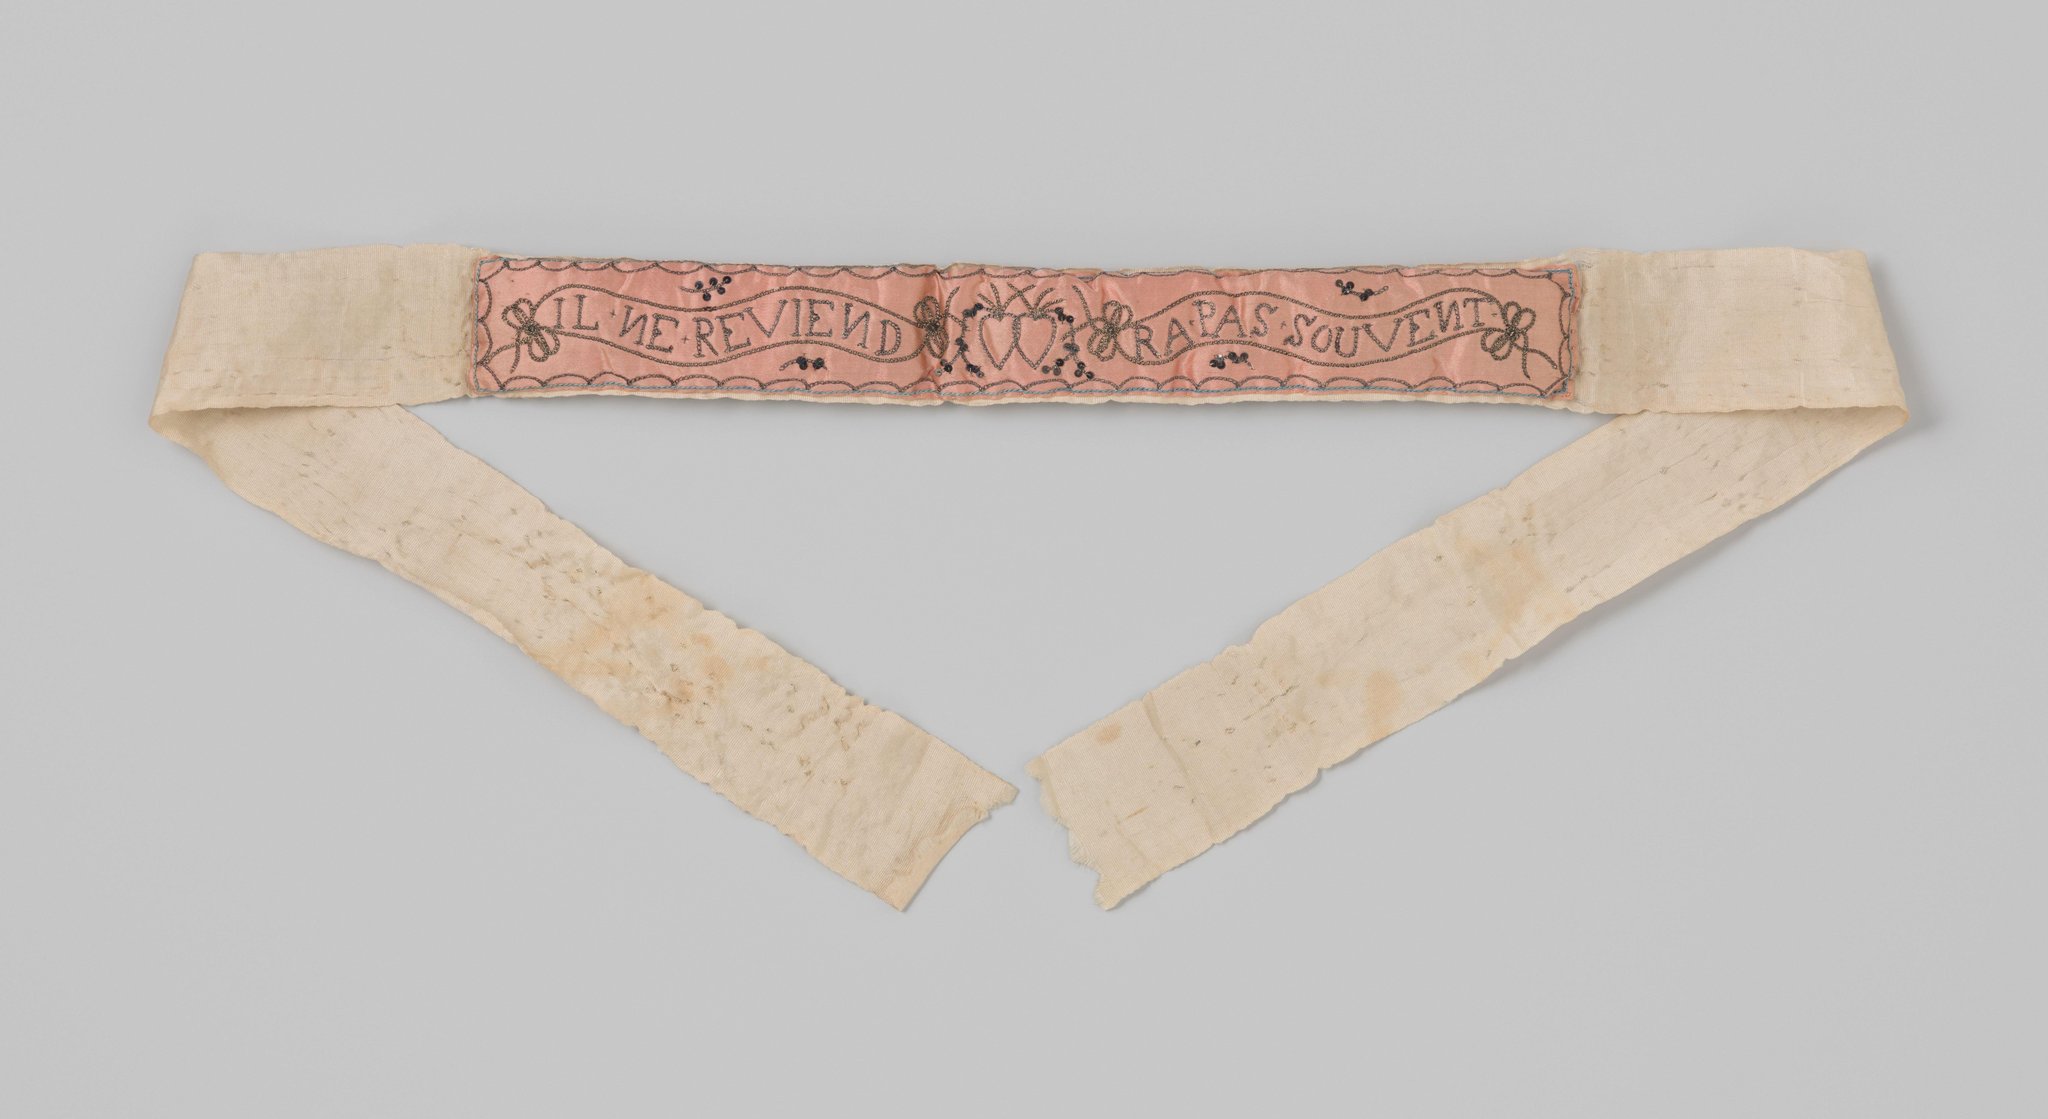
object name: garter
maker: Anonymous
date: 1815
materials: silk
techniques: embroidered, padding, weave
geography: netherlands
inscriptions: inscription: ‘IL + NE + REVIEN // DRA + PAS + SOUVENT +’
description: Garters were tied tightly around the thigh to hold up long, knitted stockings. They were often provided with amorous proverbs or dedications. Embroidered on this garter is: ‘Il ne reviendra pas souvent’ (He will not return often). This could refer to the custom in which a lover ‘conquers’ the garter and keeps it as a memento.